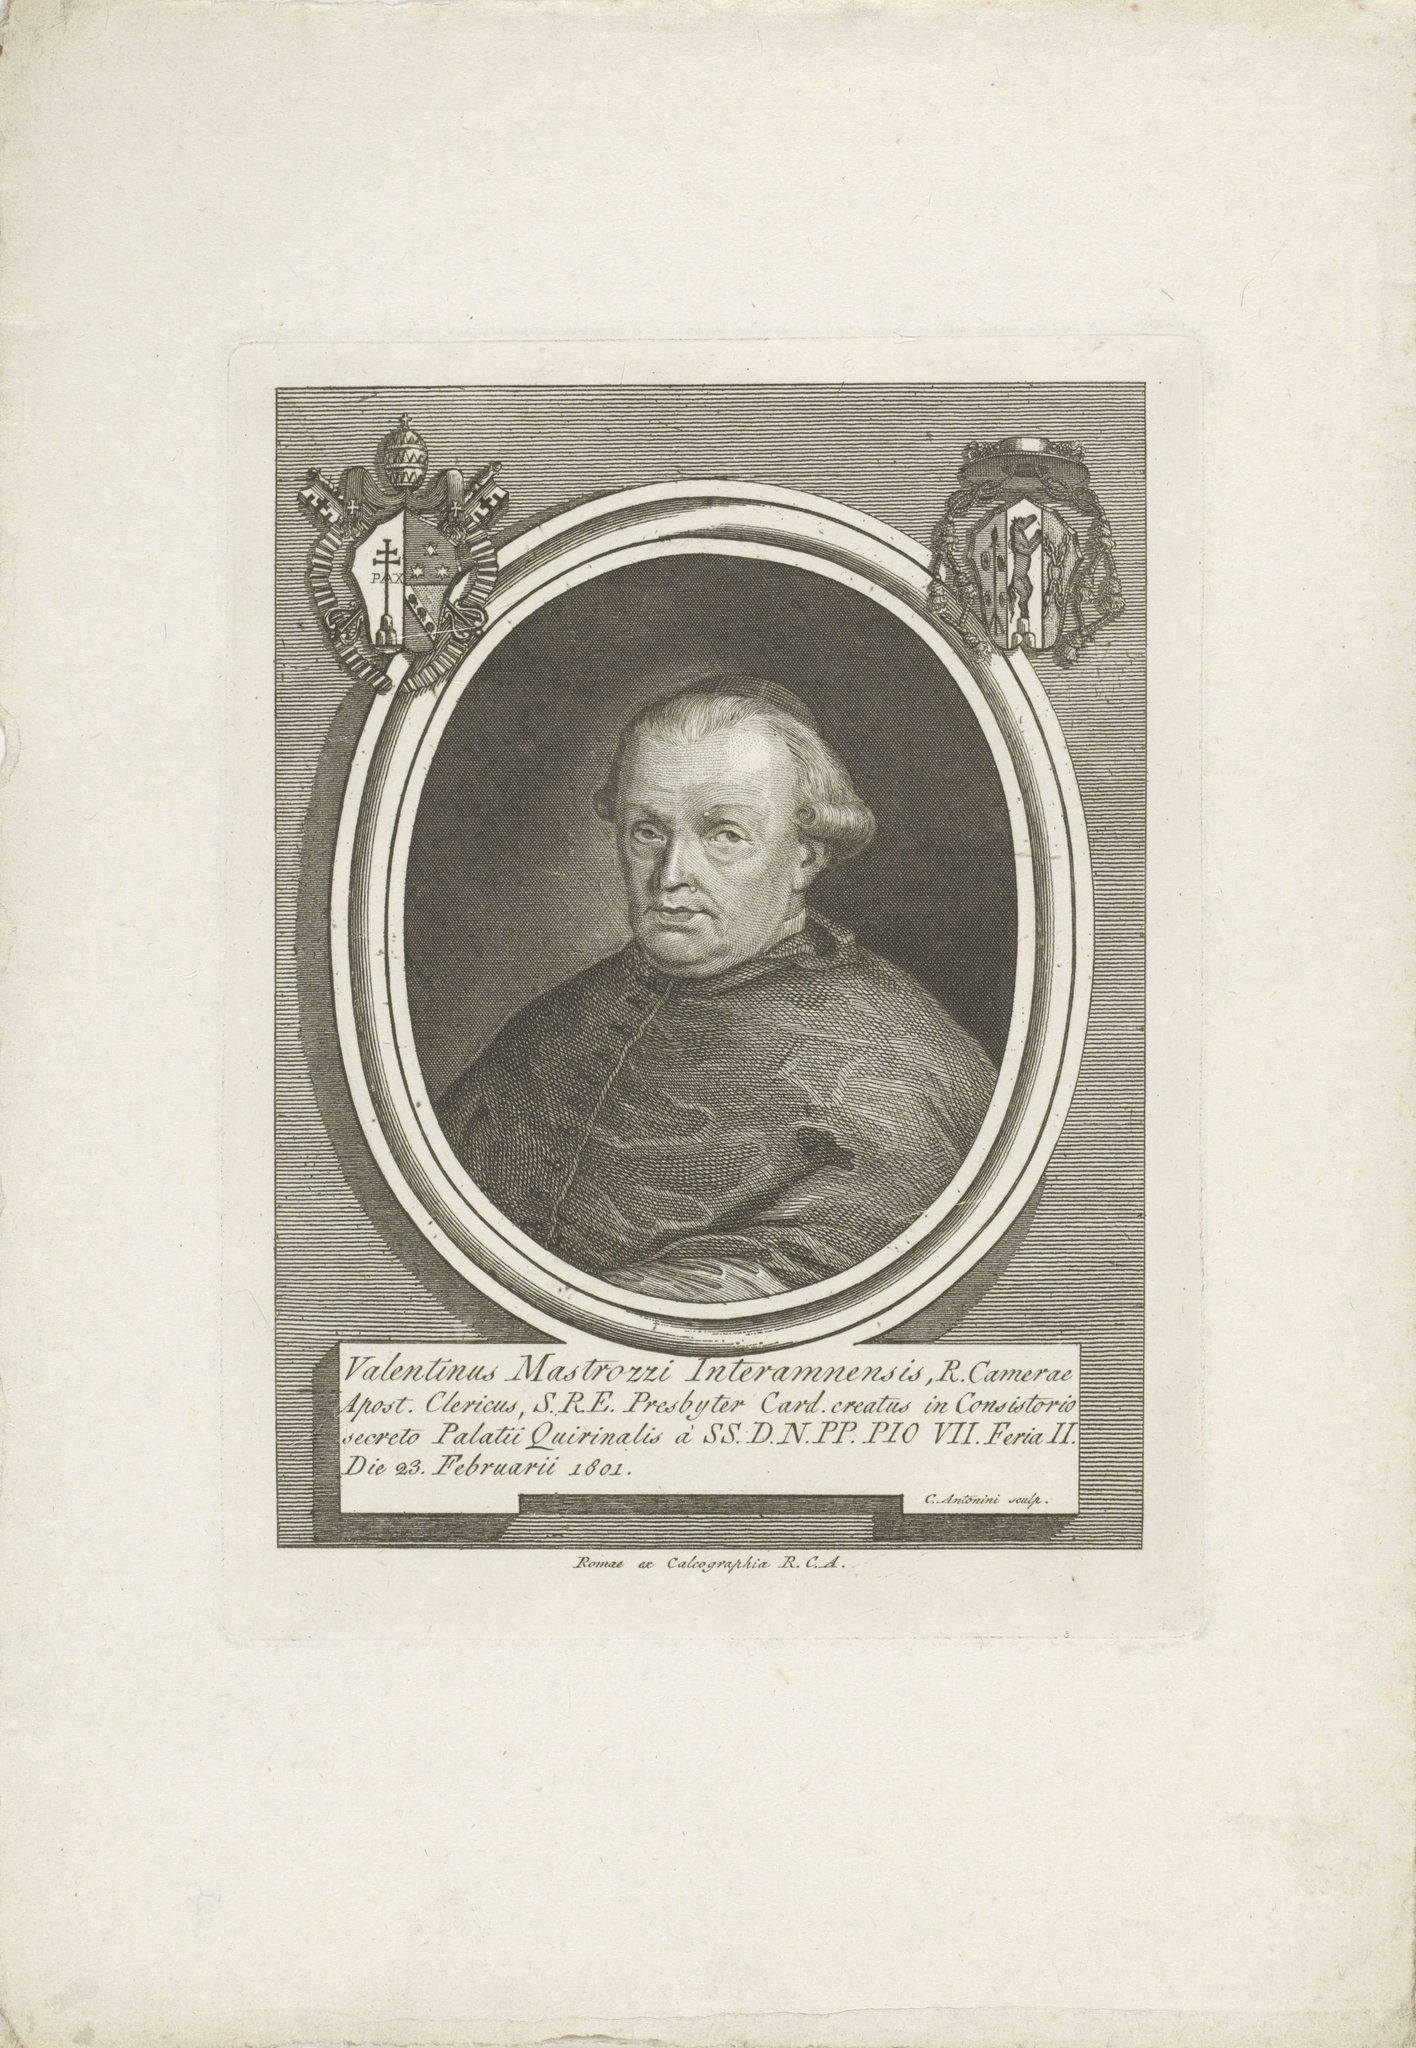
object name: print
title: Portret van Valentino Mastrozzi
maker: carlo antonini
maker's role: print maker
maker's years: 1749-1835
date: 1801-1805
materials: paper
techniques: engraving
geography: rome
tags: rome, clergyman, historical persons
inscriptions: collector's mark: Lugt 2228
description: Portret van Kardinaal Valentino Mastrozzi in een ovaal. Boven twee wapenschilden. Onder het portret een kader met tekst in het Latijn.